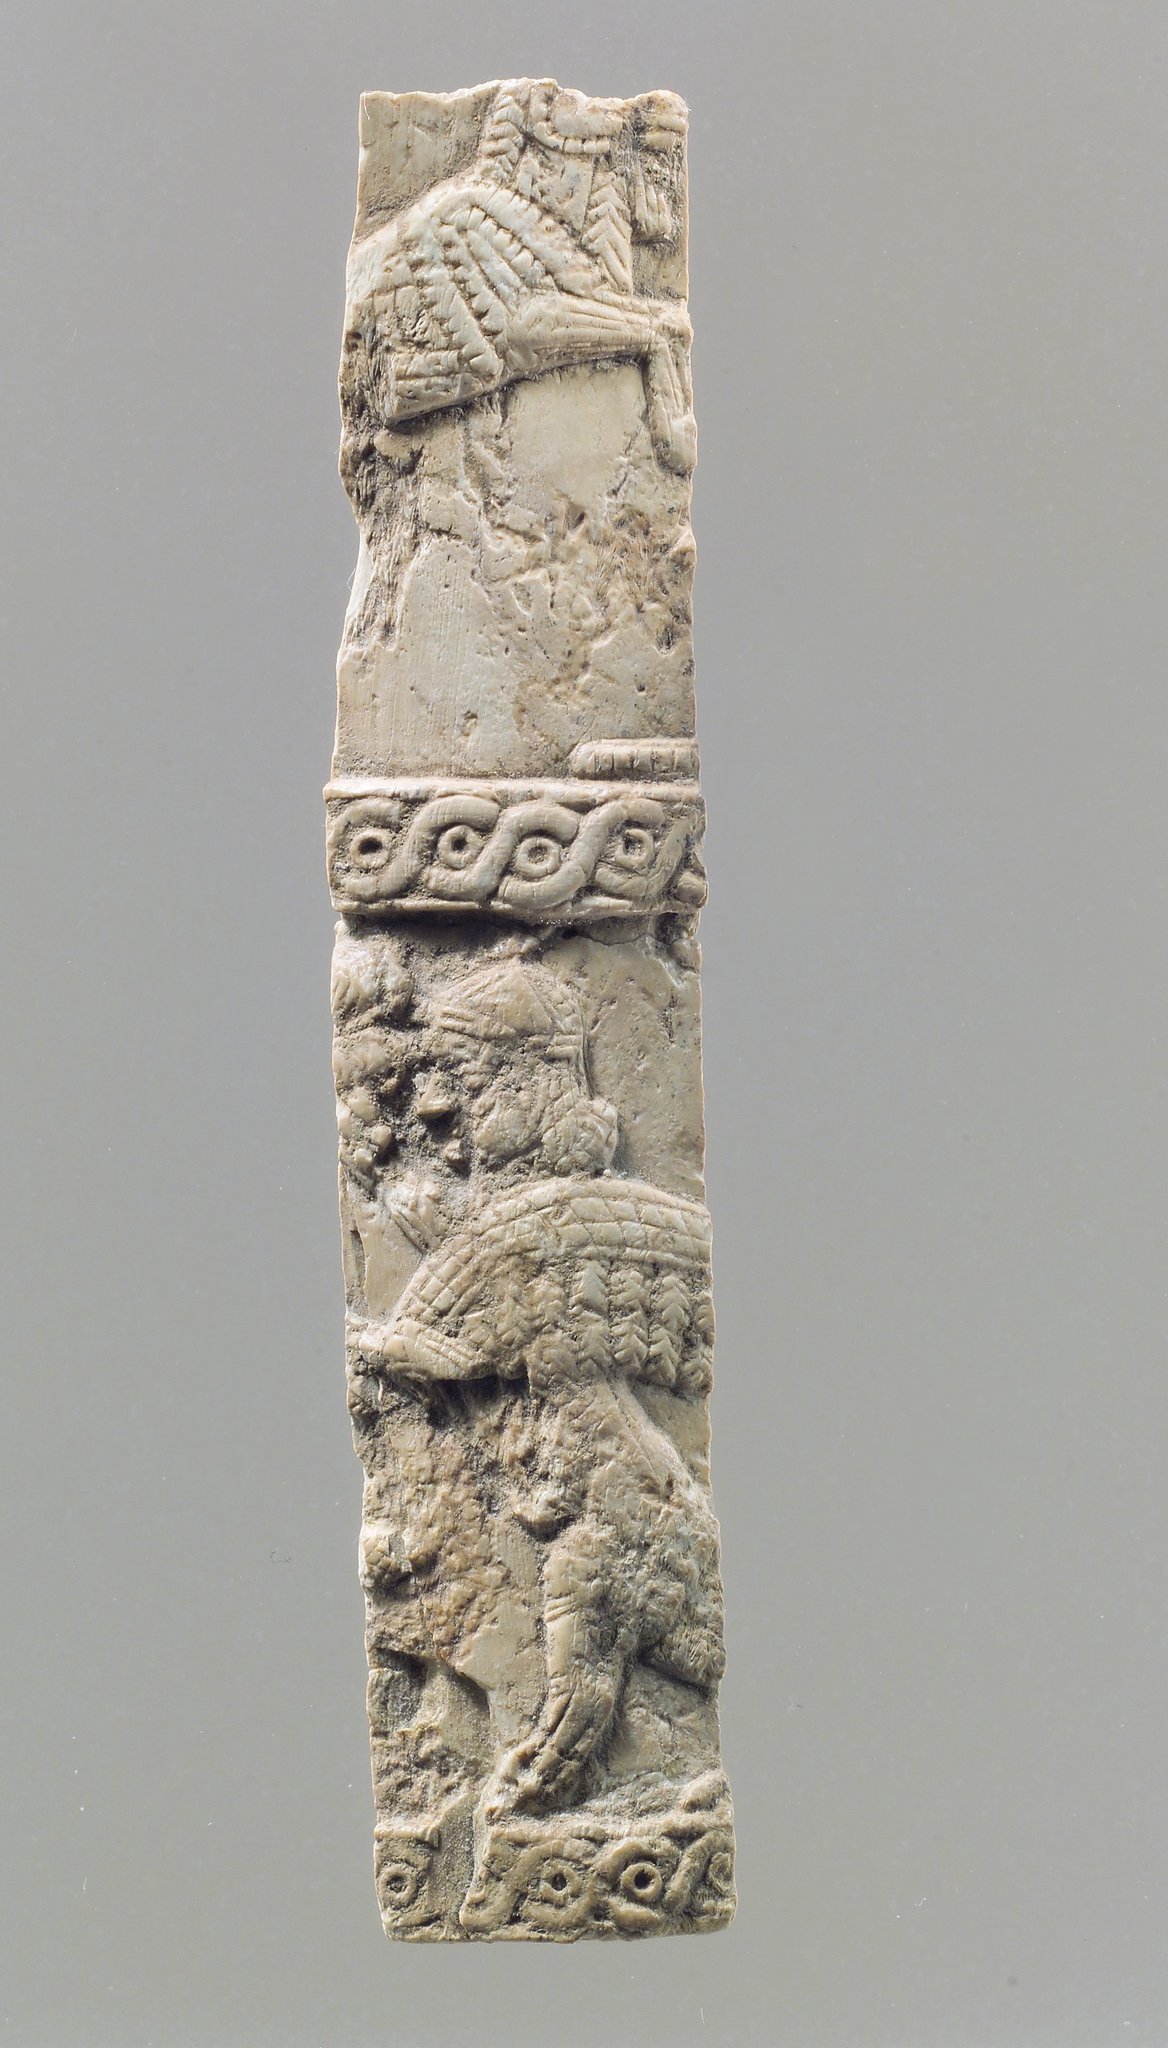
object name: pyxis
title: Pyxis fragment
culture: iranian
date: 800-601 BCE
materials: ivory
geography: iran